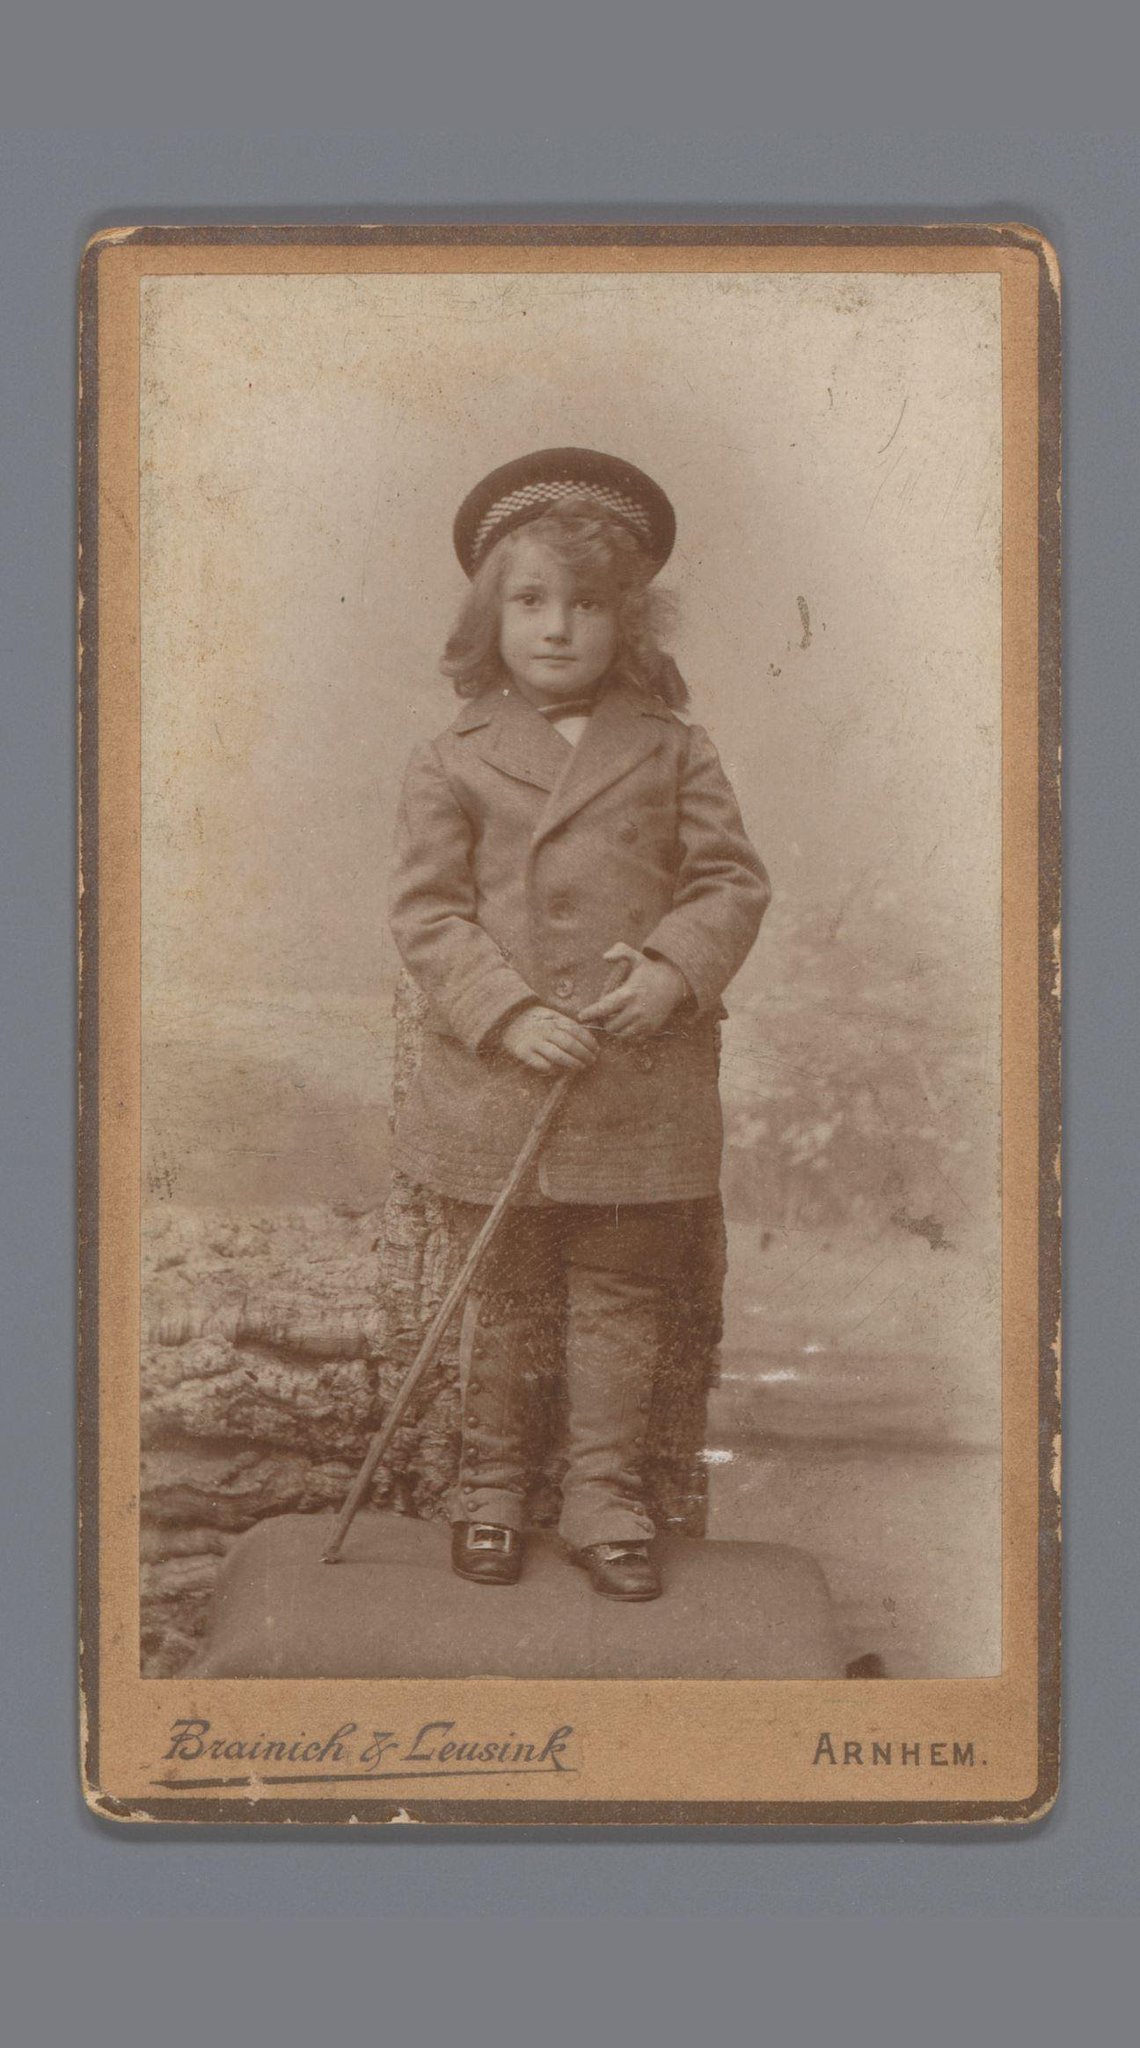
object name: photograph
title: Portret van Darwine d'Abo, vier jaar oud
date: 1881-1904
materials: paper, cardboard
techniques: collodion silver print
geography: arnhem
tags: toddler, historical persons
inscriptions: inscription: ‘De platen blijven voor nabestelling bewaard, ook worden/ vergrootingen naar ieder klein portret vervaardigd.’, address: ‘Menthenstraat No 10/ Arnhem.’